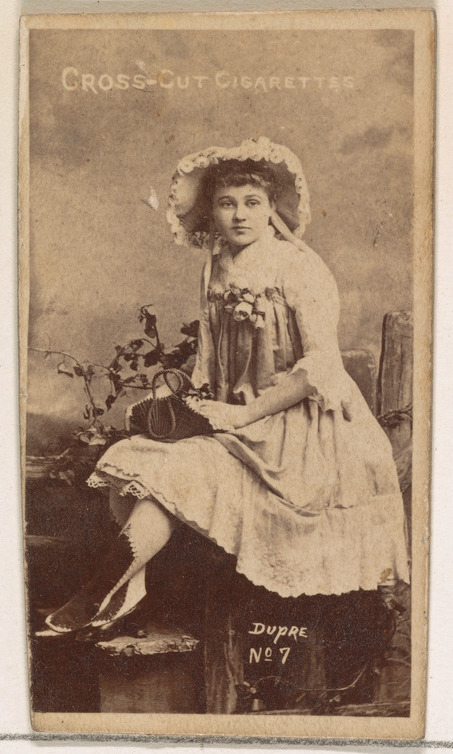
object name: print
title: Card Number 7, Dupre, from the Actors and Actresses series (N145-1) issued by Duke Sons & Co. to promote Cross Cut Cigarettes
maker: w. duke, sons & co.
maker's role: publisher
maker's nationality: american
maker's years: 1870-1920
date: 1880-1889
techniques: albumen silver print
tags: portraits,women,actresses